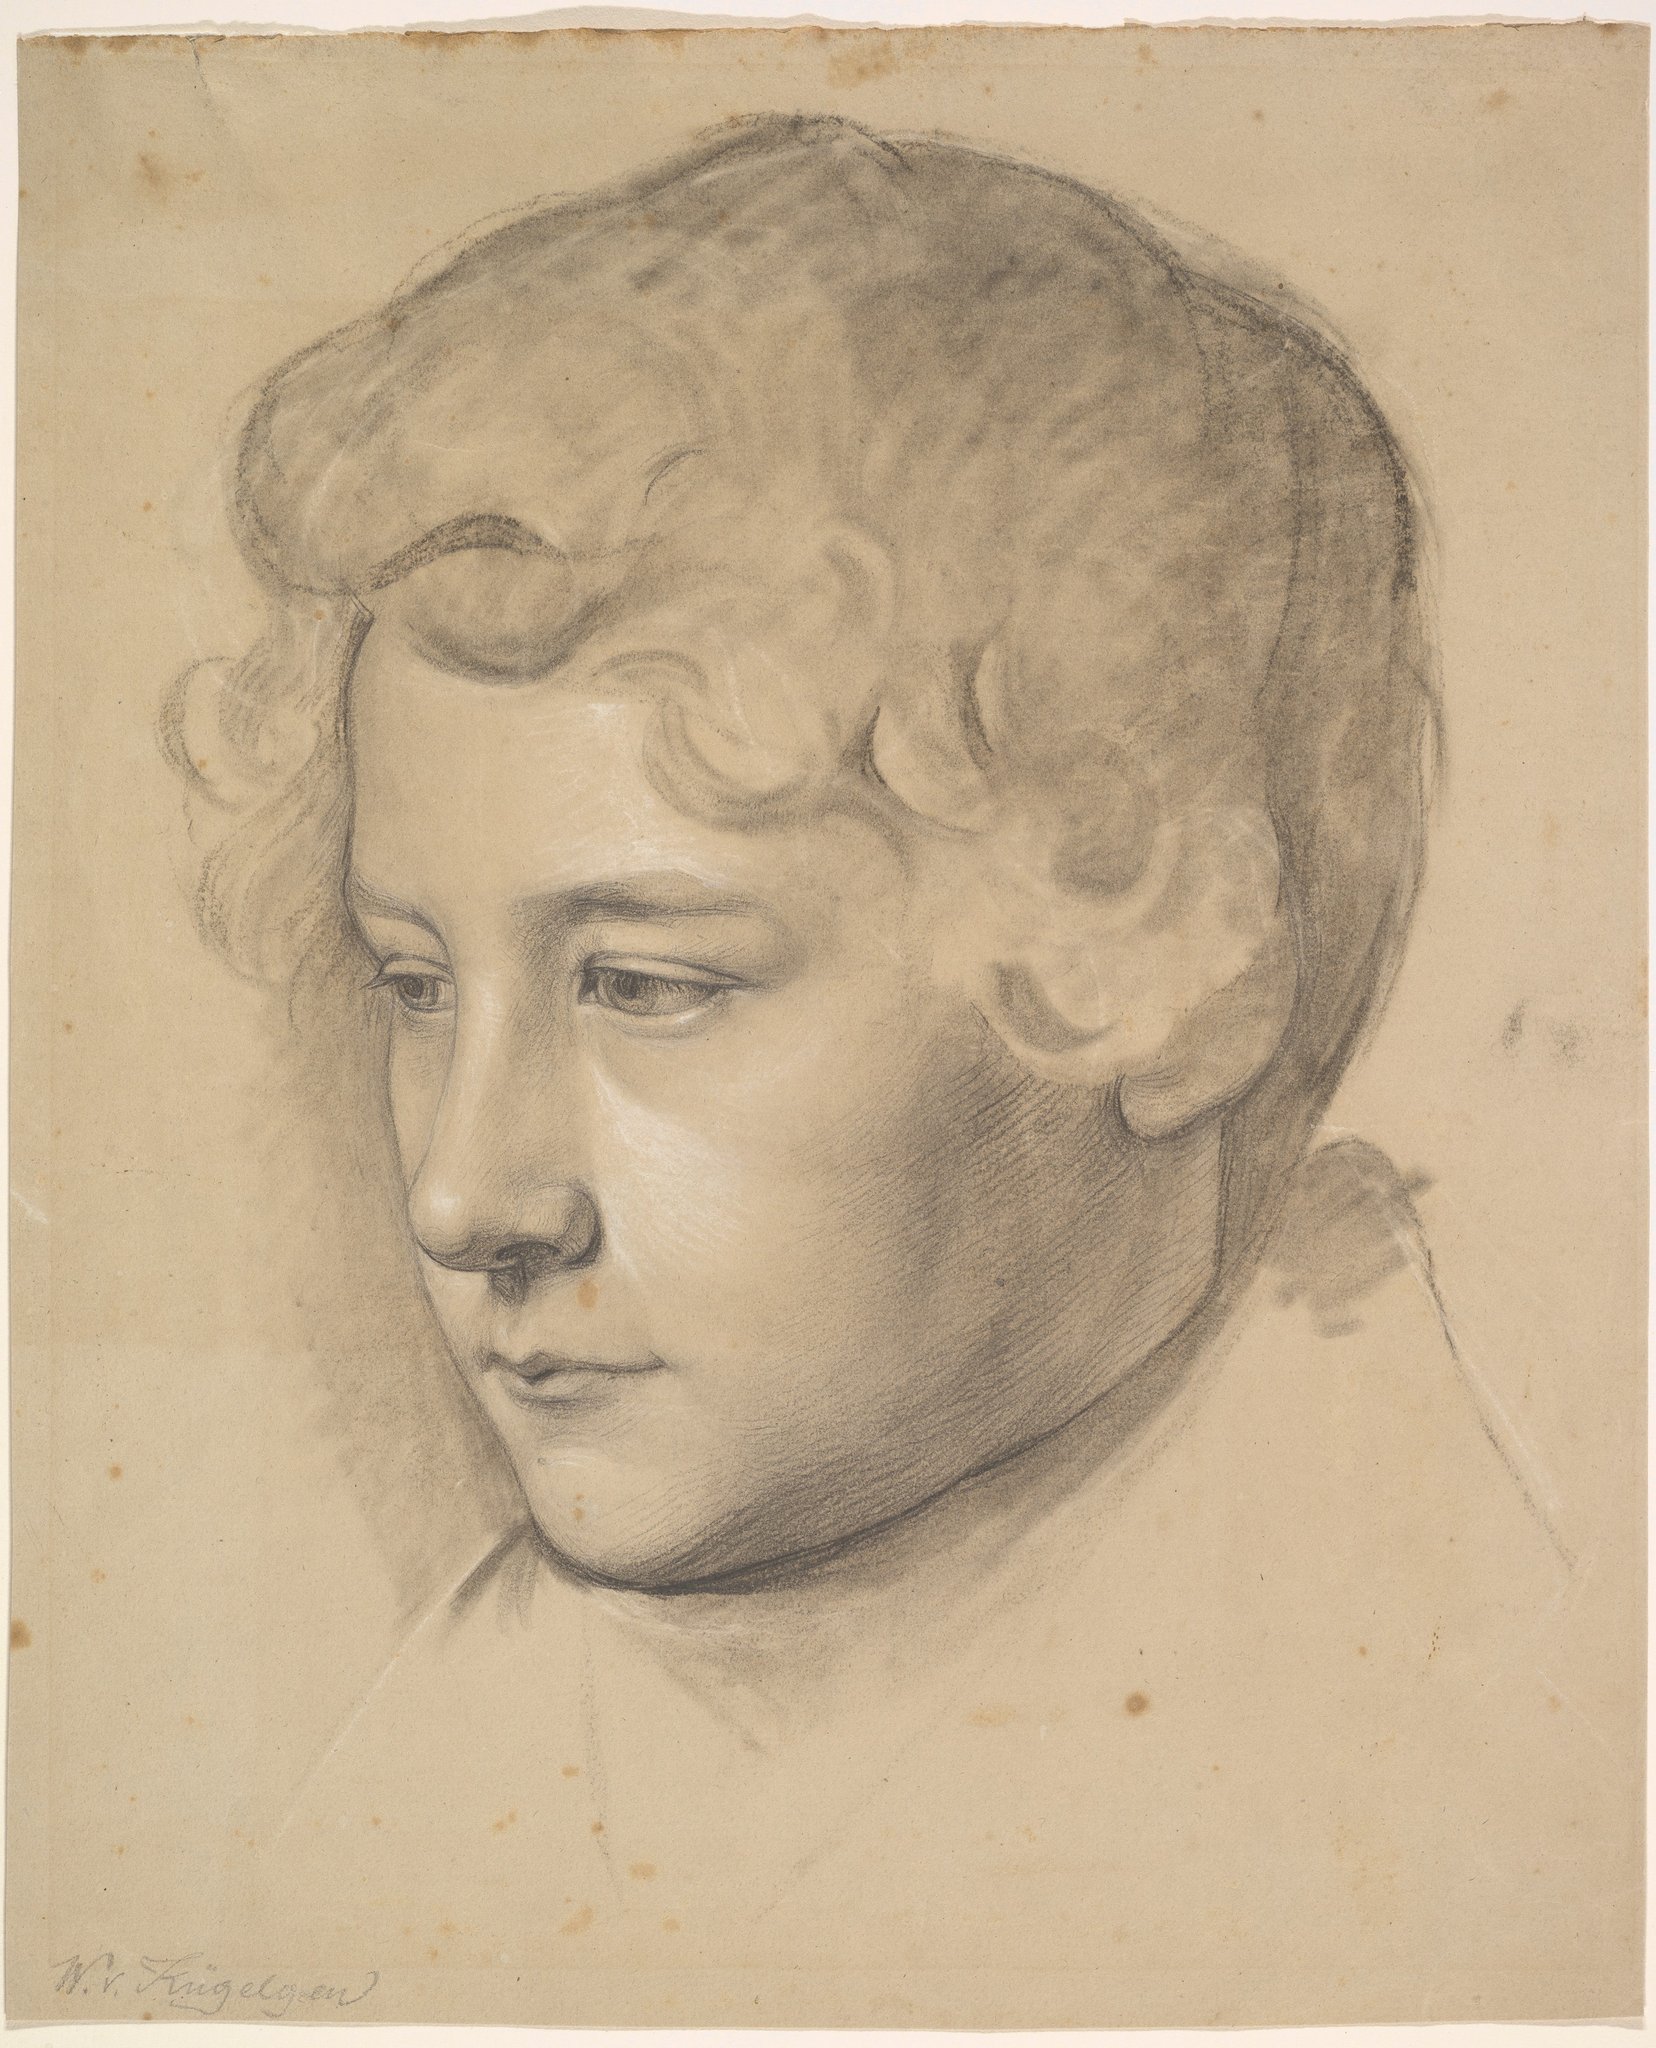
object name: drawing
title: Portrait of a Young Man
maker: wilhelm von kügelgen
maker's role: artist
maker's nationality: german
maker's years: 1802-1867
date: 1834-1866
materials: chalk, paper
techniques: heightening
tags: men,portraits